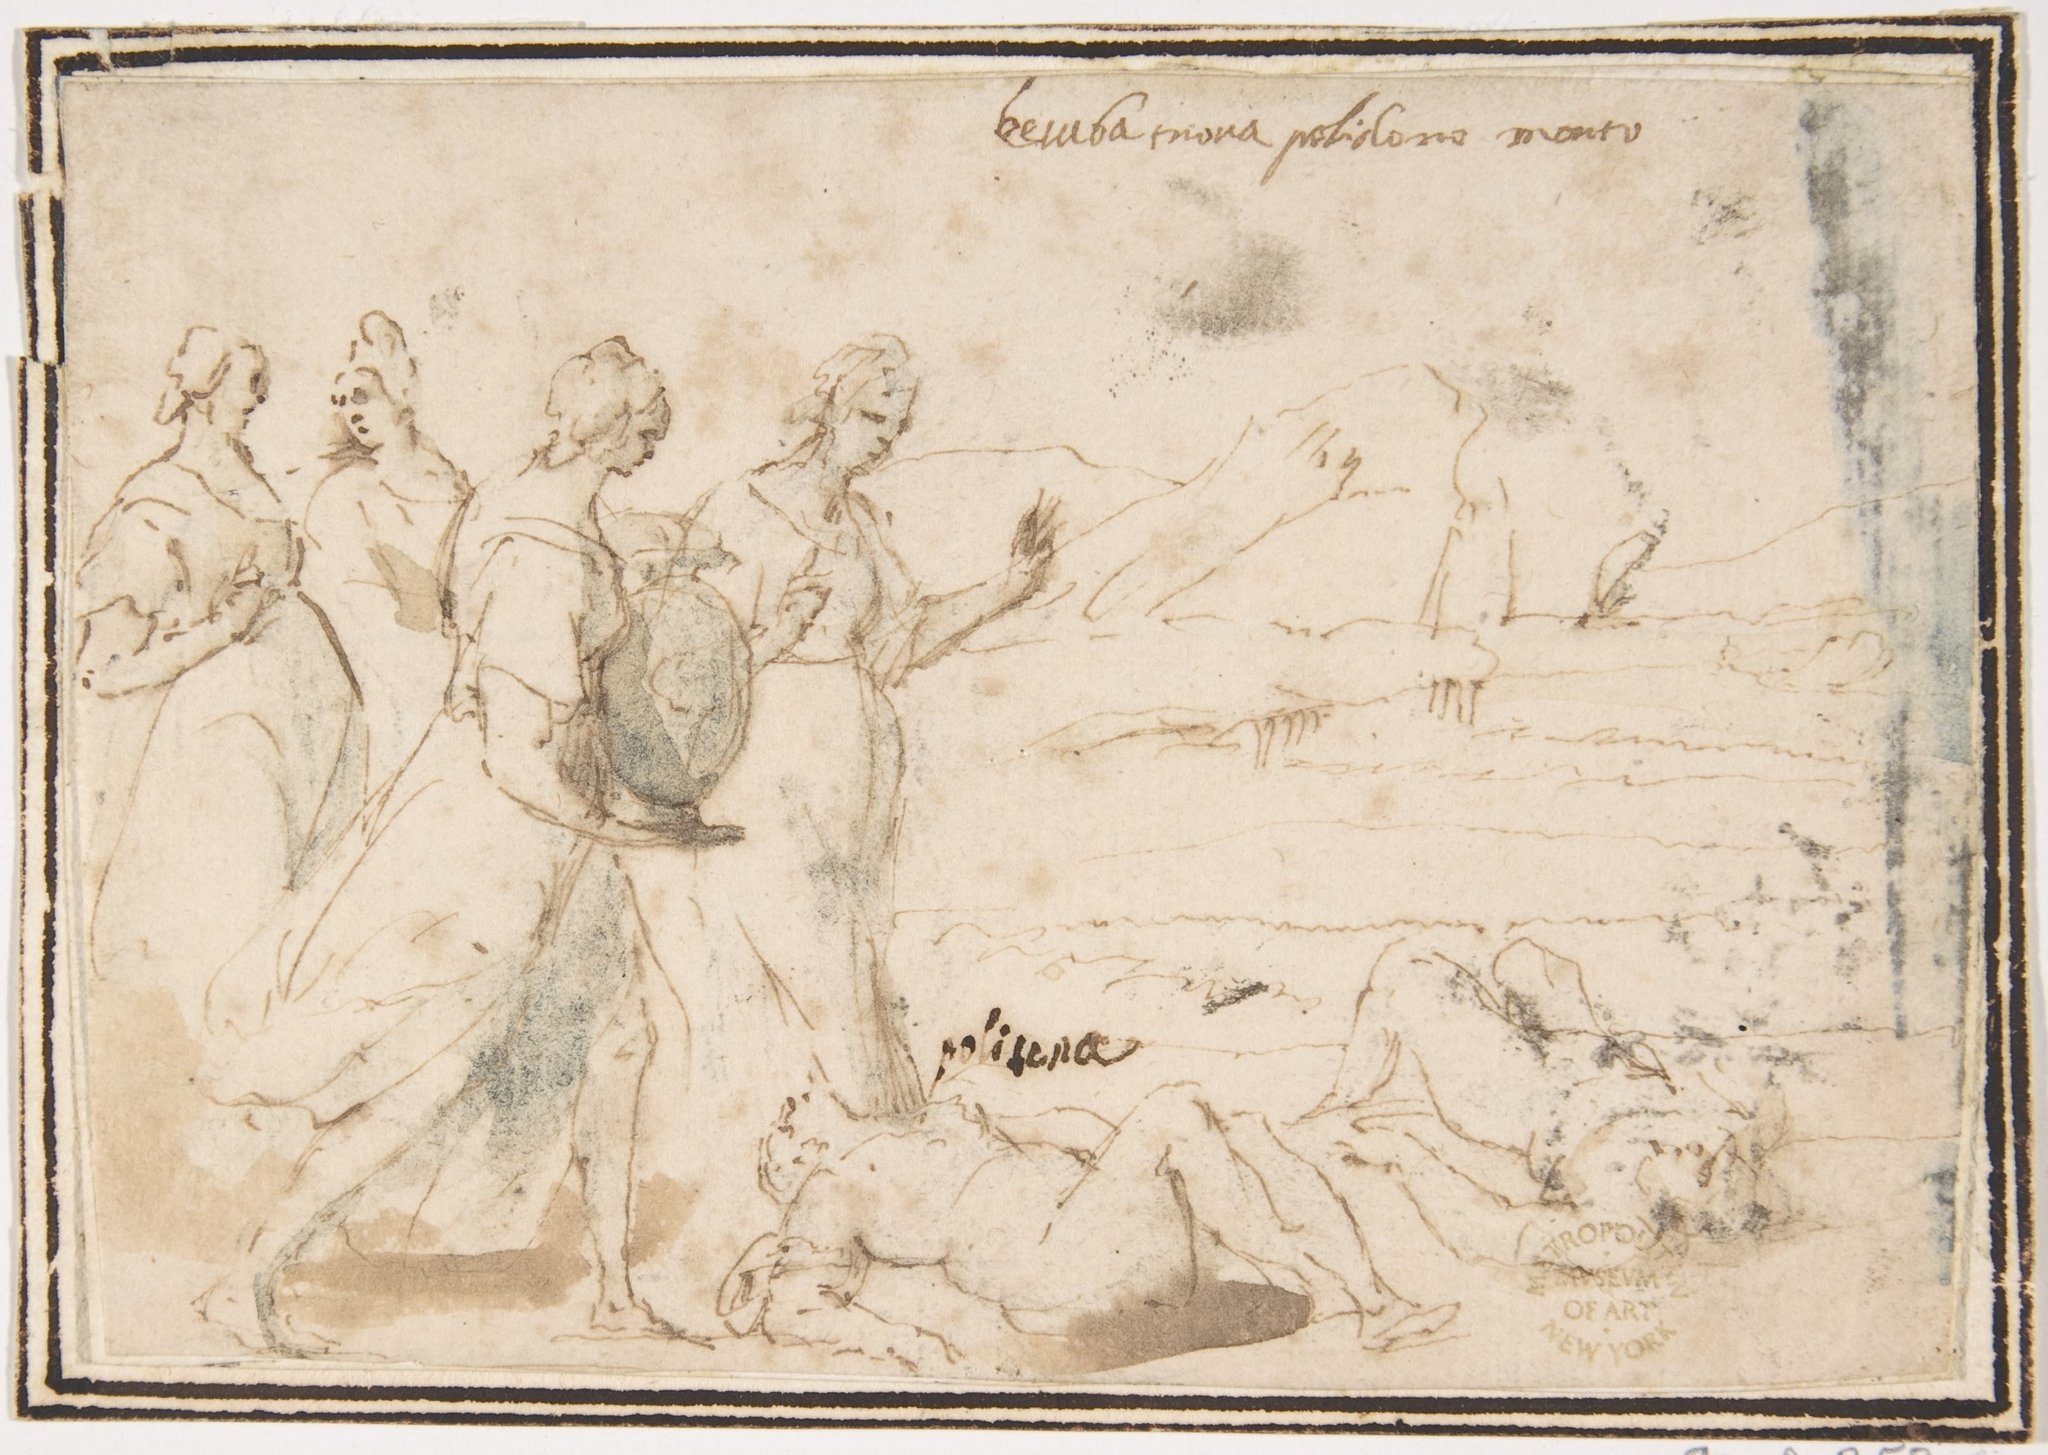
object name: drawing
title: The Death of Polyxena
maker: francesco allegrini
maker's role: artist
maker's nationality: italian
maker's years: 1615-1679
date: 1624-1663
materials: ink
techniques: brush, pen, wash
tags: women,death